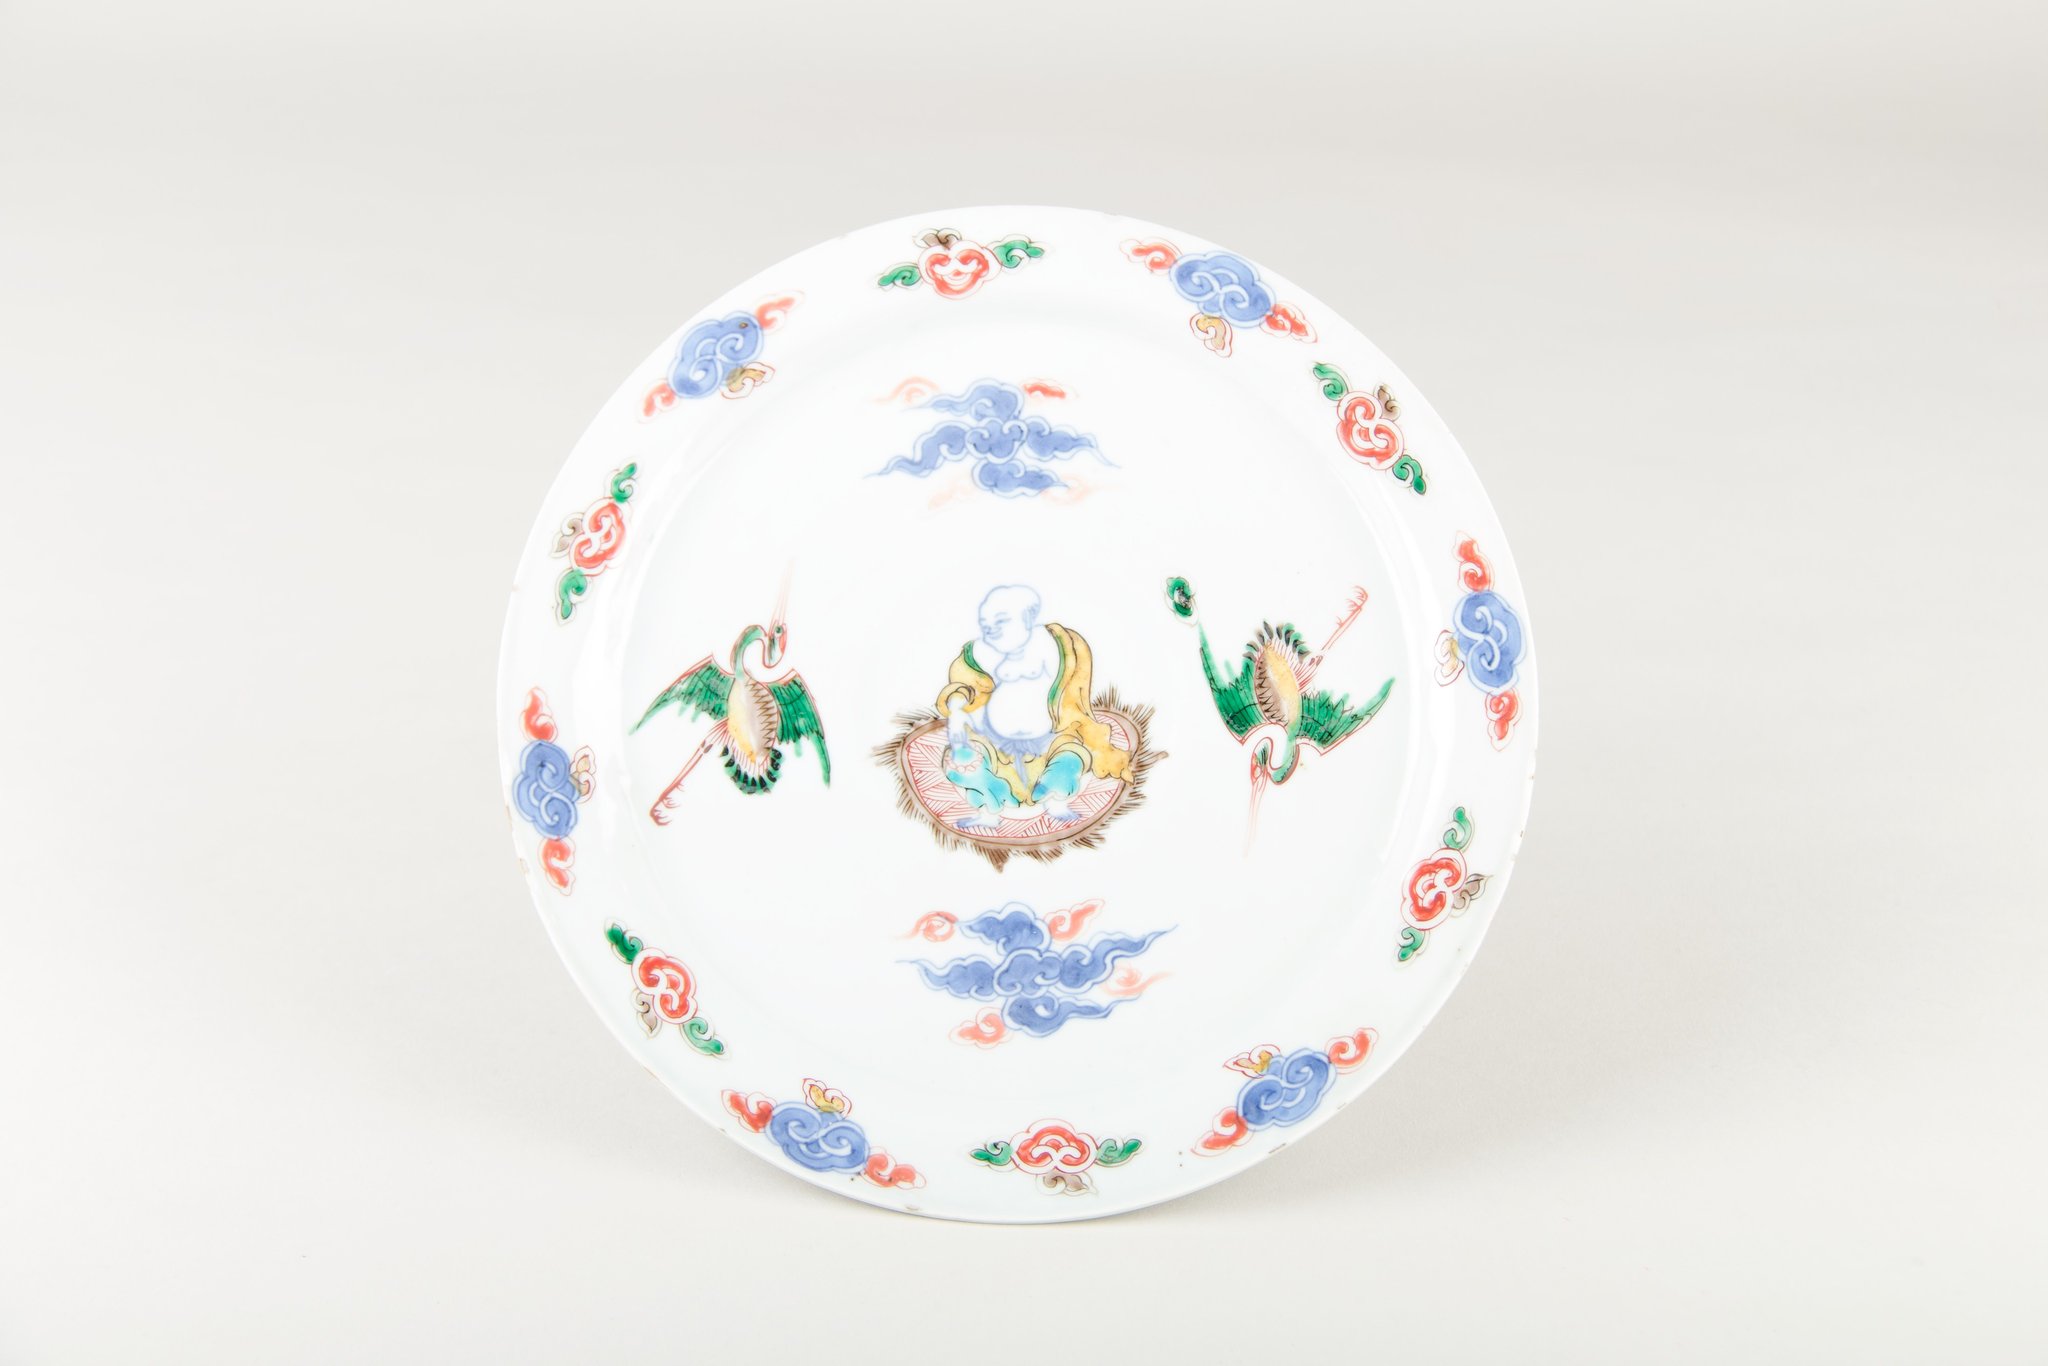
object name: plate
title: Plate with Buddhist monk Budai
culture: chinese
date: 1634-1666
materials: cobalt, enamel, porcelain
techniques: overglaze, painting, polychrome, underglaze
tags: human figures,birds